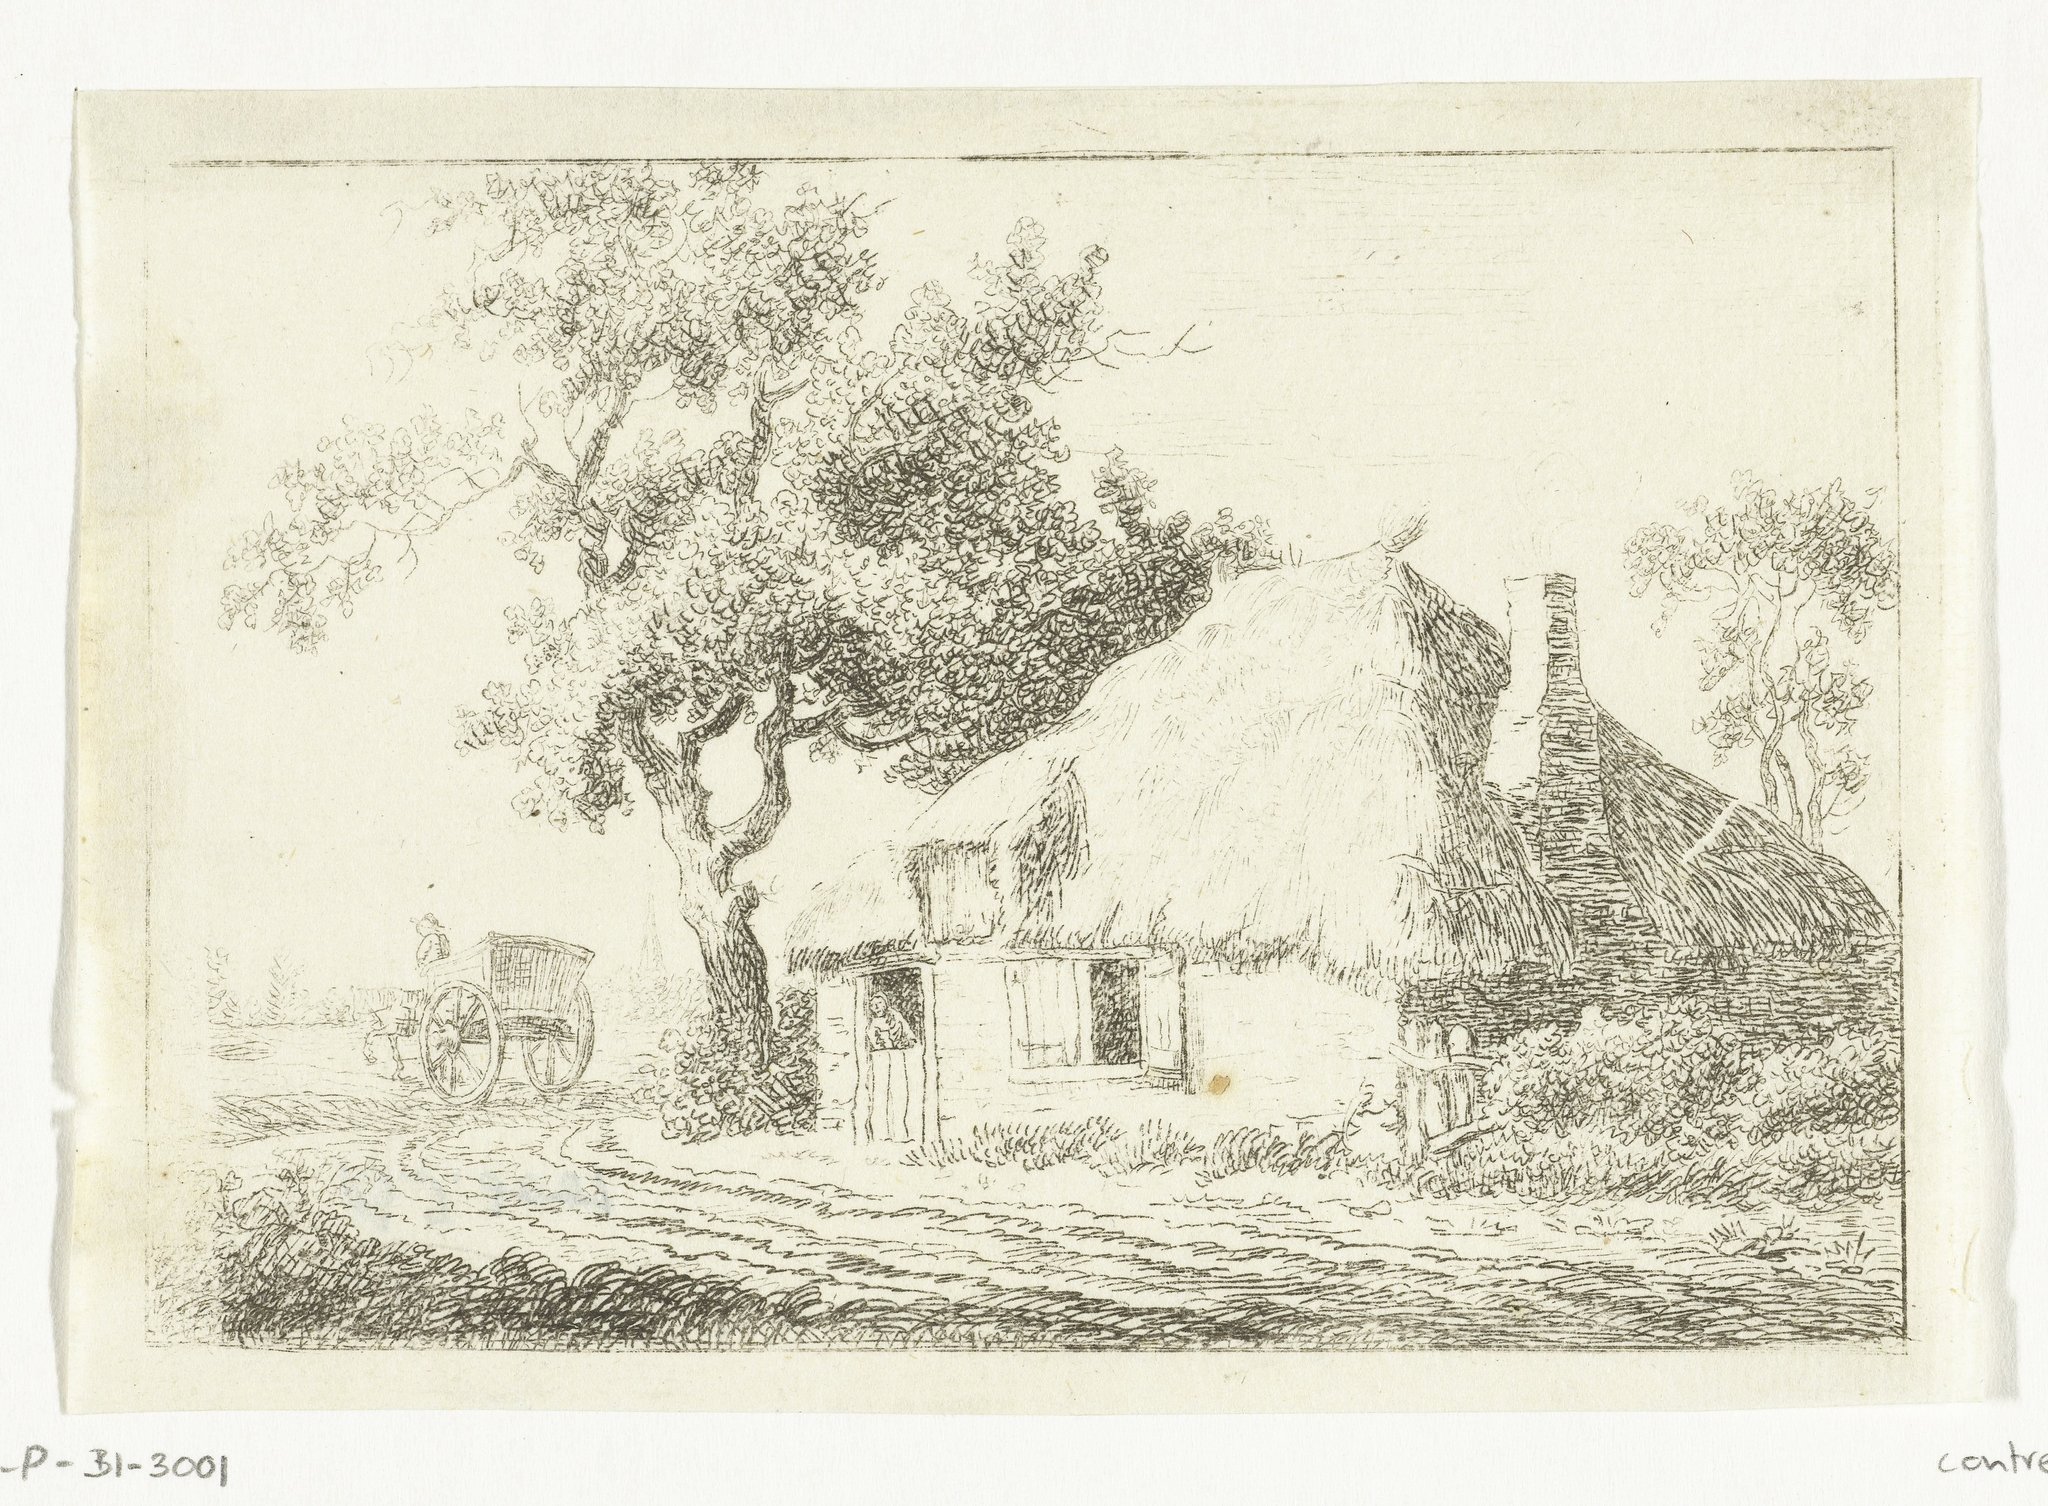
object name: print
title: Paard en wagen bij boerderij buiten Zwolle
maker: anthonie van den bos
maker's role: draughtsman, print maker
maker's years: 1763-1838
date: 1778-1838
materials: paper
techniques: printmaking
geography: netherlands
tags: farm or solitary house in landscape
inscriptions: collector's mark: Lugt 2228